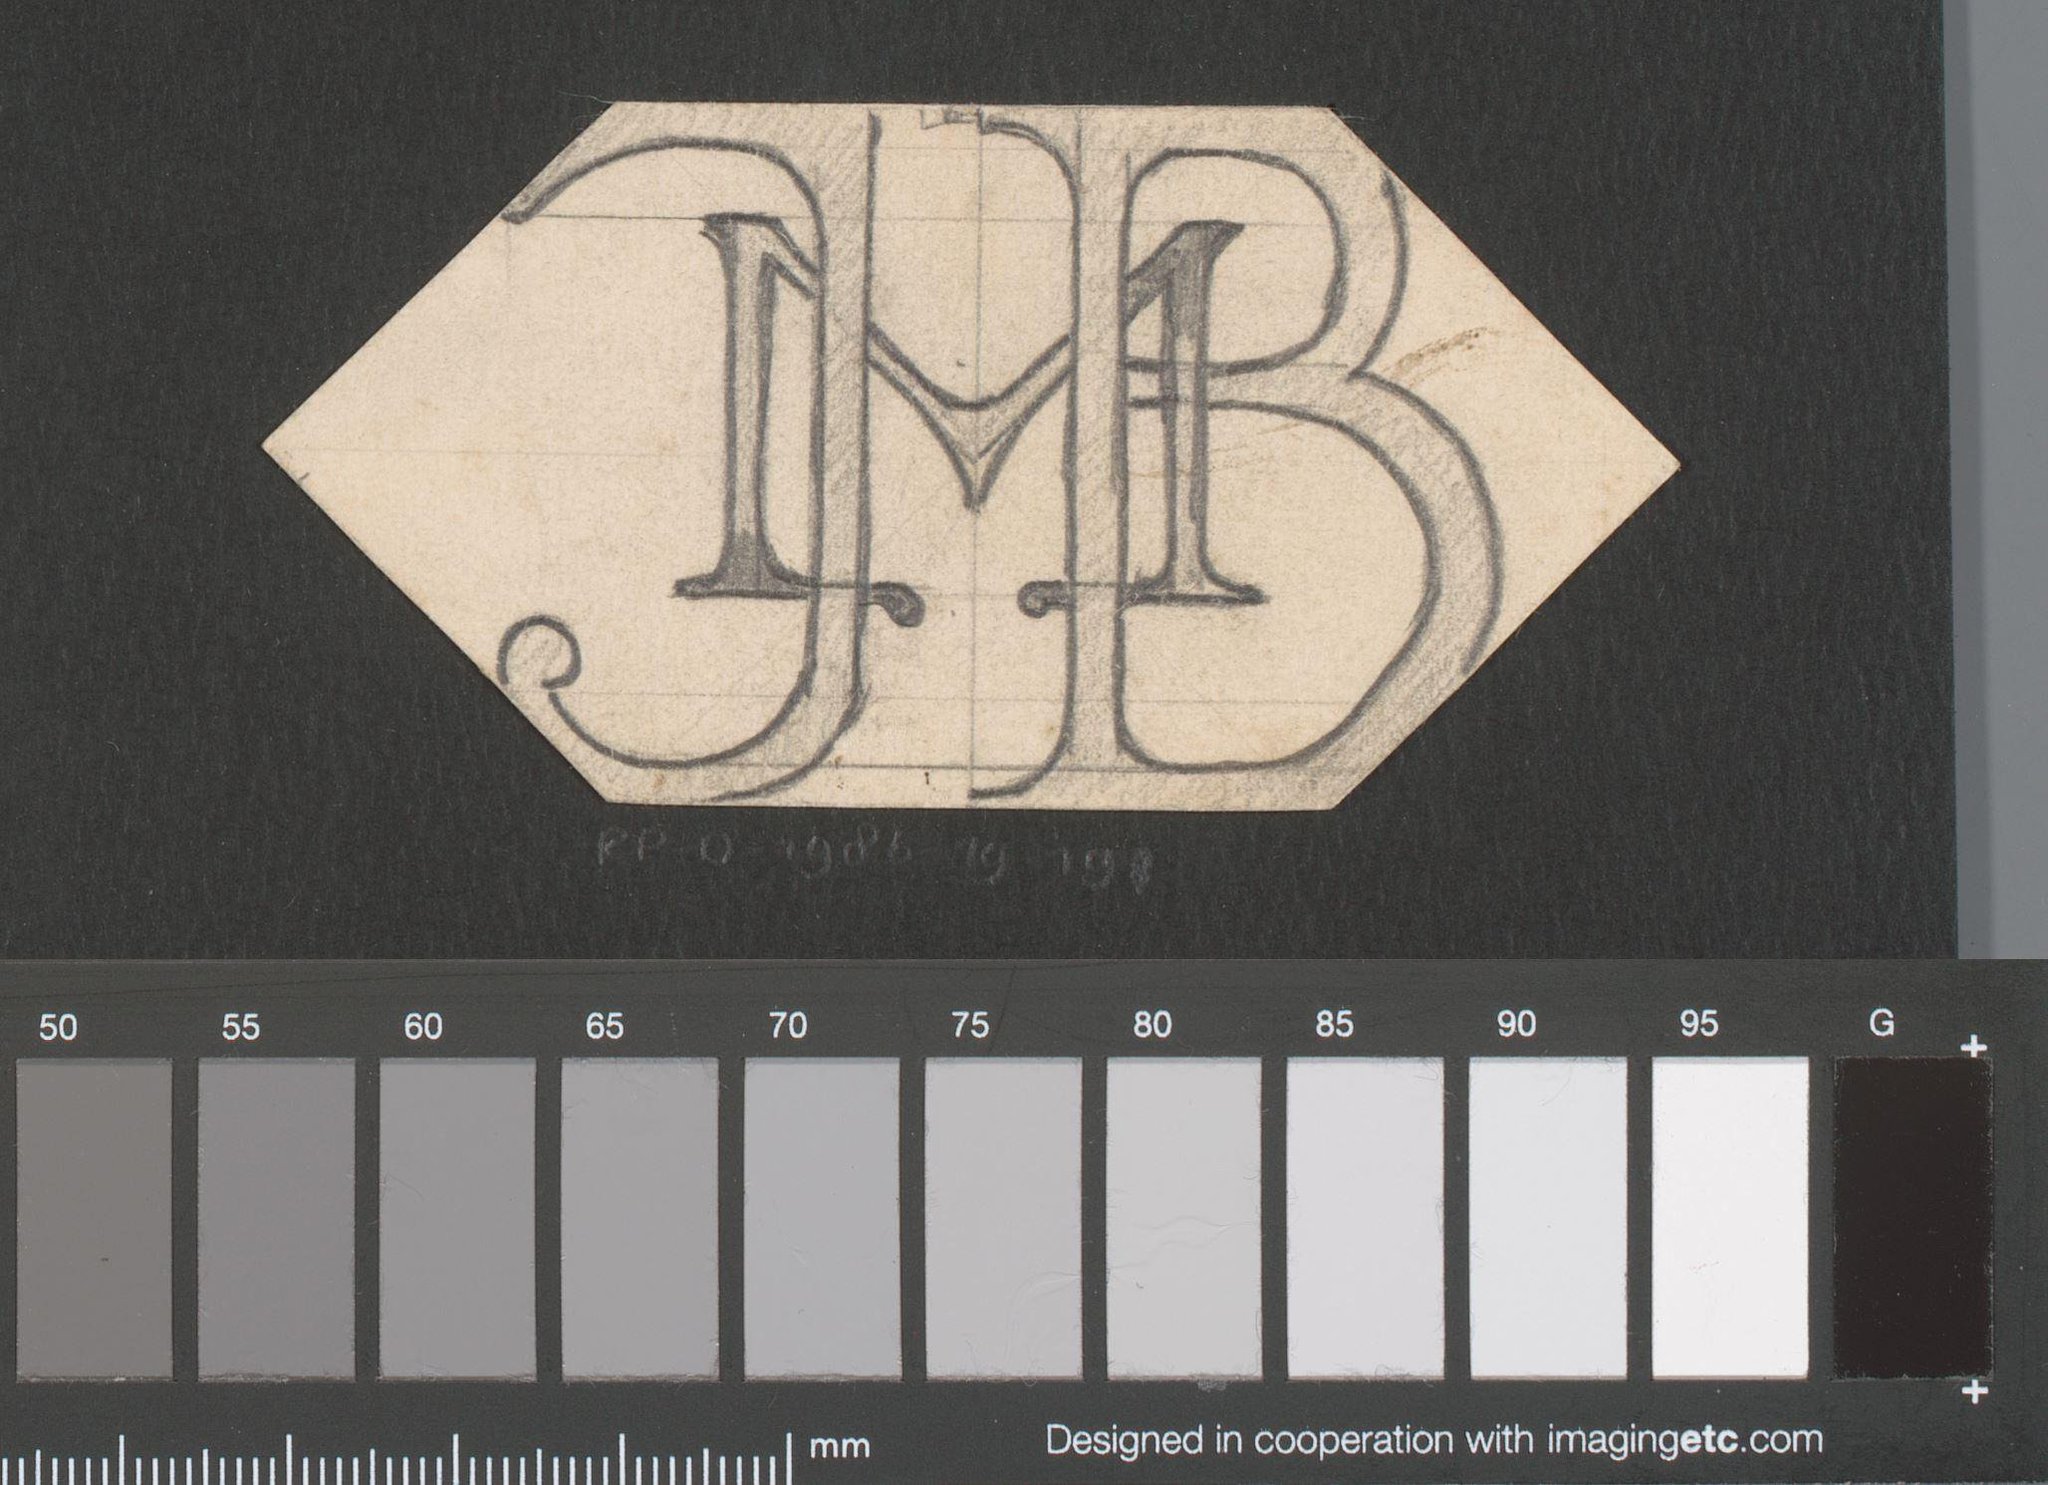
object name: drawing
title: Monogram JMB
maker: reinier willem petrus de vries (1874-1953)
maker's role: draughtsman, print maker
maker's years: 1874-1953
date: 1884-1952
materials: paper, pencil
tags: magic mathematical figures; magic numbers, words, monograms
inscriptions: collector's mark: ‘R:MVS.’